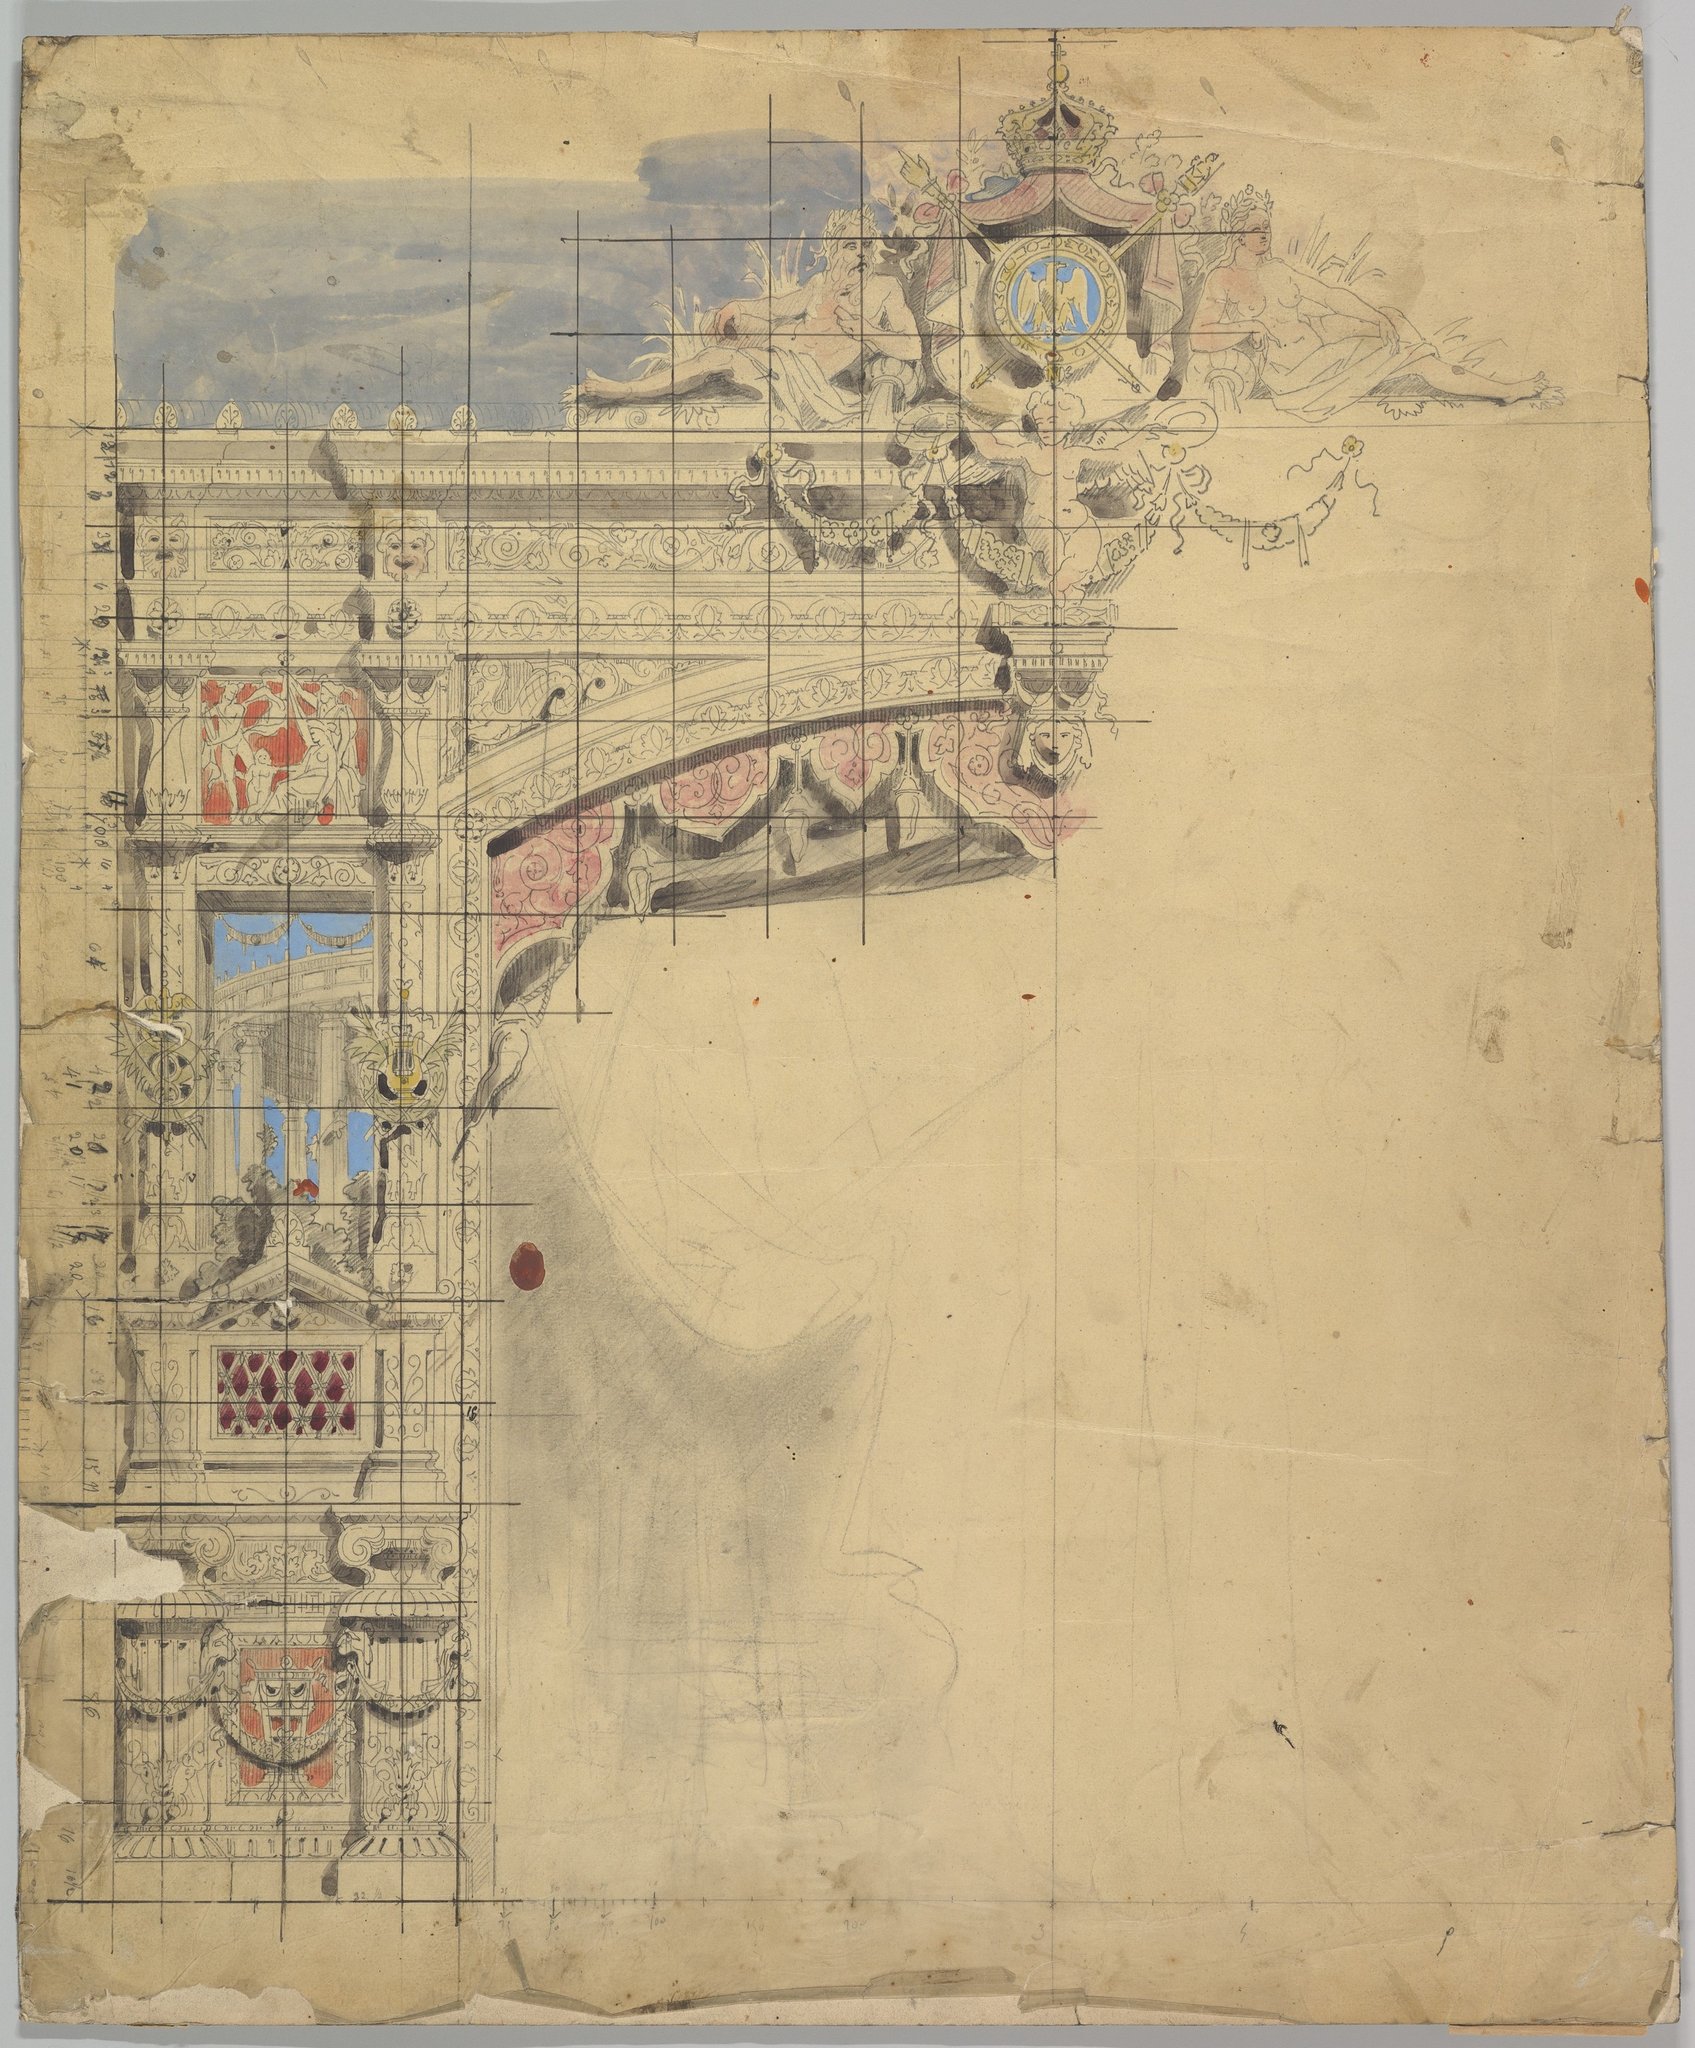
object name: drawing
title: Design for a Stage Set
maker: eugène cicéri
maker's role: artist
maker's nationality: french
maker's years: 1813-1890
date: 1830-1890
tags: theatre,stage design